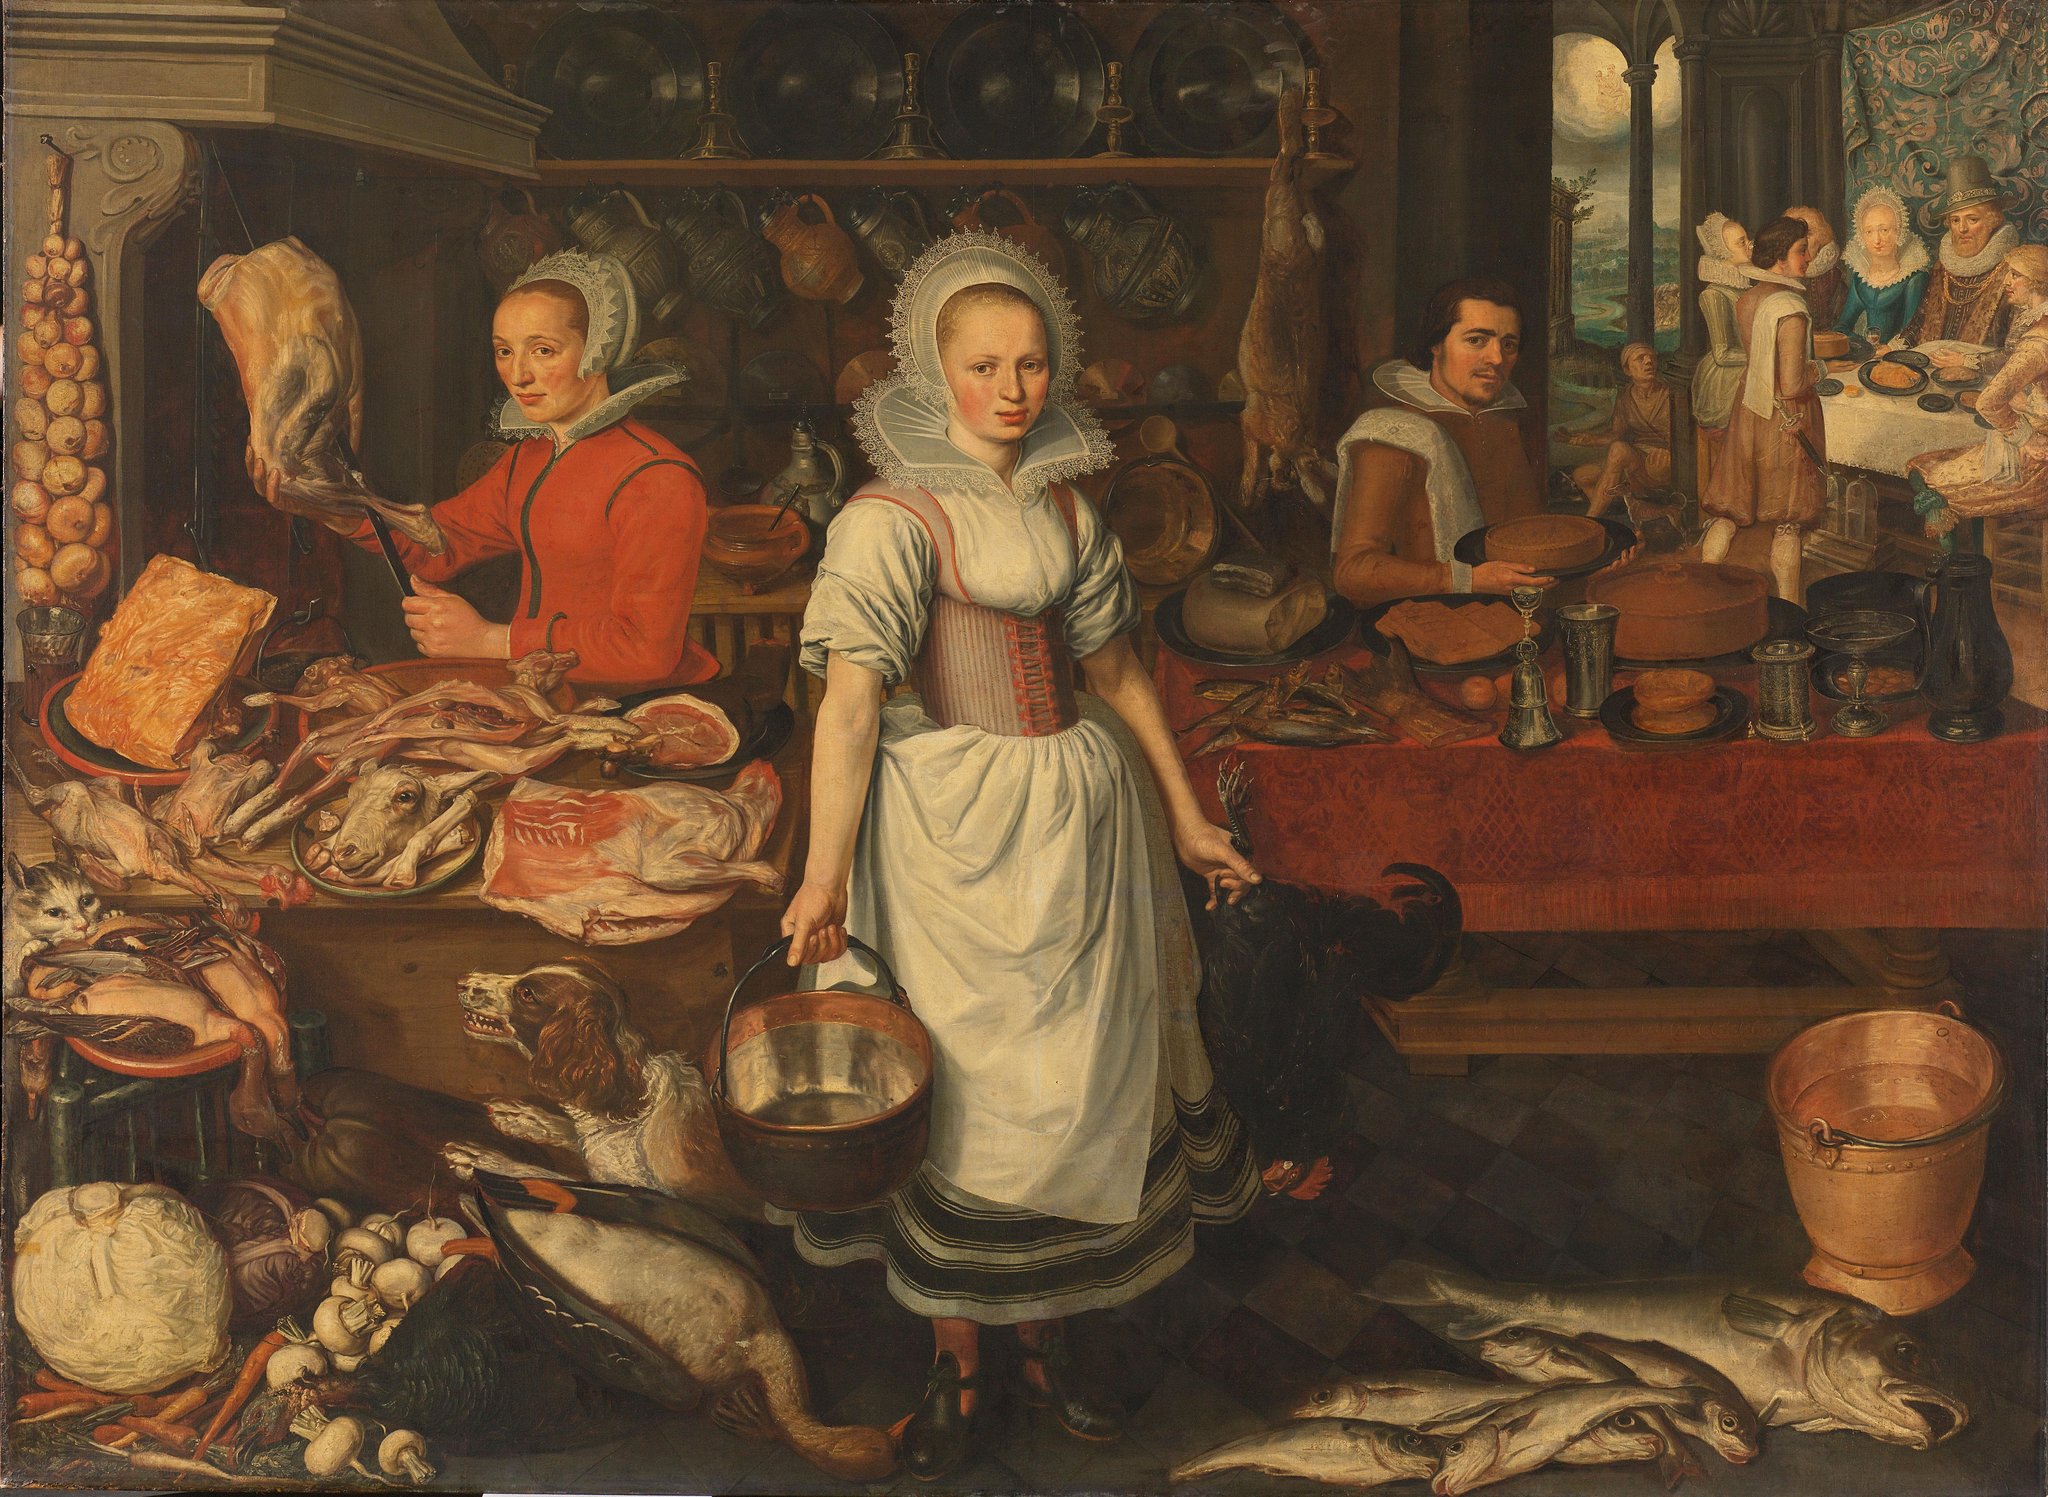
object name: painting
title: Kitchen Scene with the Parable of the Rich Man and Poor Lazarus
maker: pieter cornelisz. van rijck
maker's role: painter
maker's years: 1567-1628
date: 1610-1620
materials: canvas, oil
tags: the rich man (dives) is feasting, while poor lazarus is starving at the gate (dogs licking lazarus' sores) (luke 16:19-31), meat; still life of meat, kitchen-maid, kitchen servant, kitchen-interior with foodstuffs in foreground (dutch: 'keukenstuk'), fish; still life of fishes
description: Keukeninterieur met de gelijkenis van de rijke man en de arme Lazarus. In een keuken bereiden twee keukenmeiden een feestmaal. Links rijgt een meid een stuk vlees aan het spit, de andere meid heeft een koperen ketel in een hand en een dode haan in de ander. Uitgestald liggen stukken vlees, groente (kolen, rapen en wortels), gevogelte, een dode haas en vissen. Tussen de etenswaren blaft een hond naar een kat. Rechts een tafel waarop pasteien, kaas, brood, zilveren bekers en drinkschalen staan. Tegen de achterwand hangen kruiken aan een plank, op de plank staan borden en kandelaars. Rechts op de achtergrond de rijke man met zijn gezin aan een banket, bij de deur zit Lazarus op de vloer.